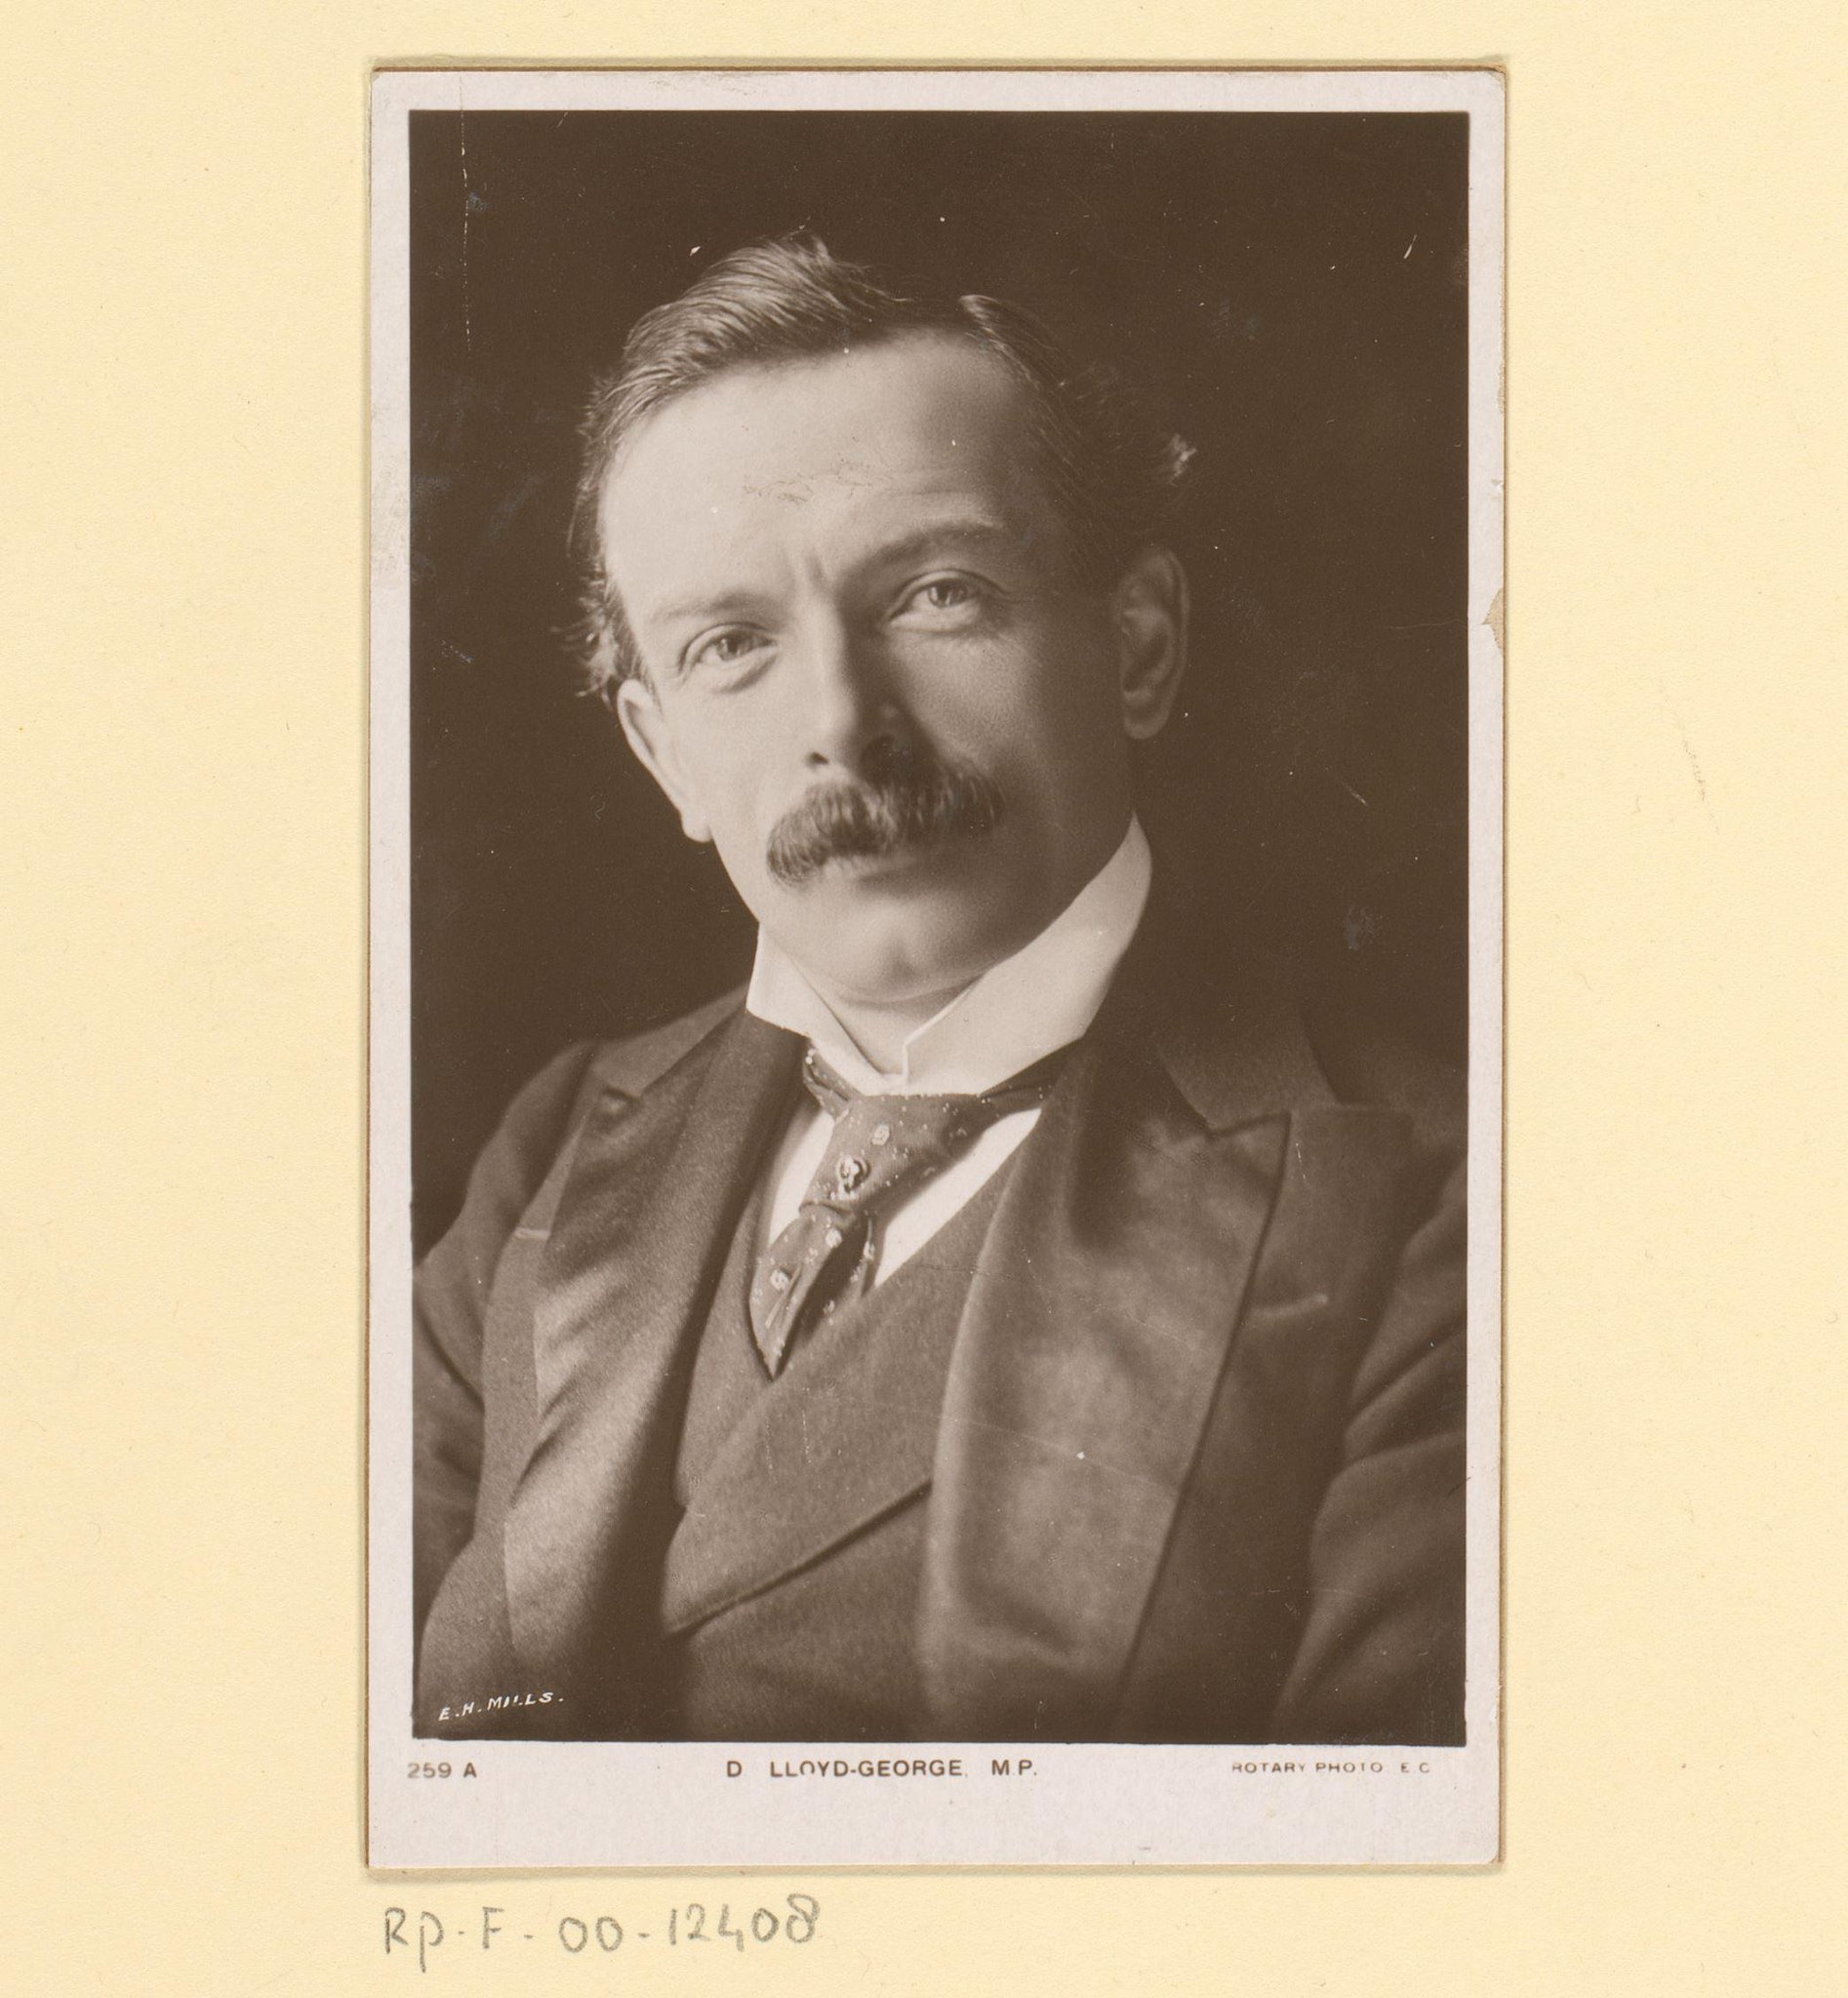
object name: photograph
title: Portret van David Lloyd George, premier van het Verenigd Koninkrijk tussen 1916 en 1922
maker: ernest herbert mills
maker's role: fotograaf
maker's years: 1874-1942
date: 1916-1922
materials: paper, cardboard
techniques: gelatin silver print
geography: london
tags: historical persons, politician, e.g. party leader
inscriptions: inscription: ‘D. LLOYD-GEORGE M.P.’, number: ‘259 A’